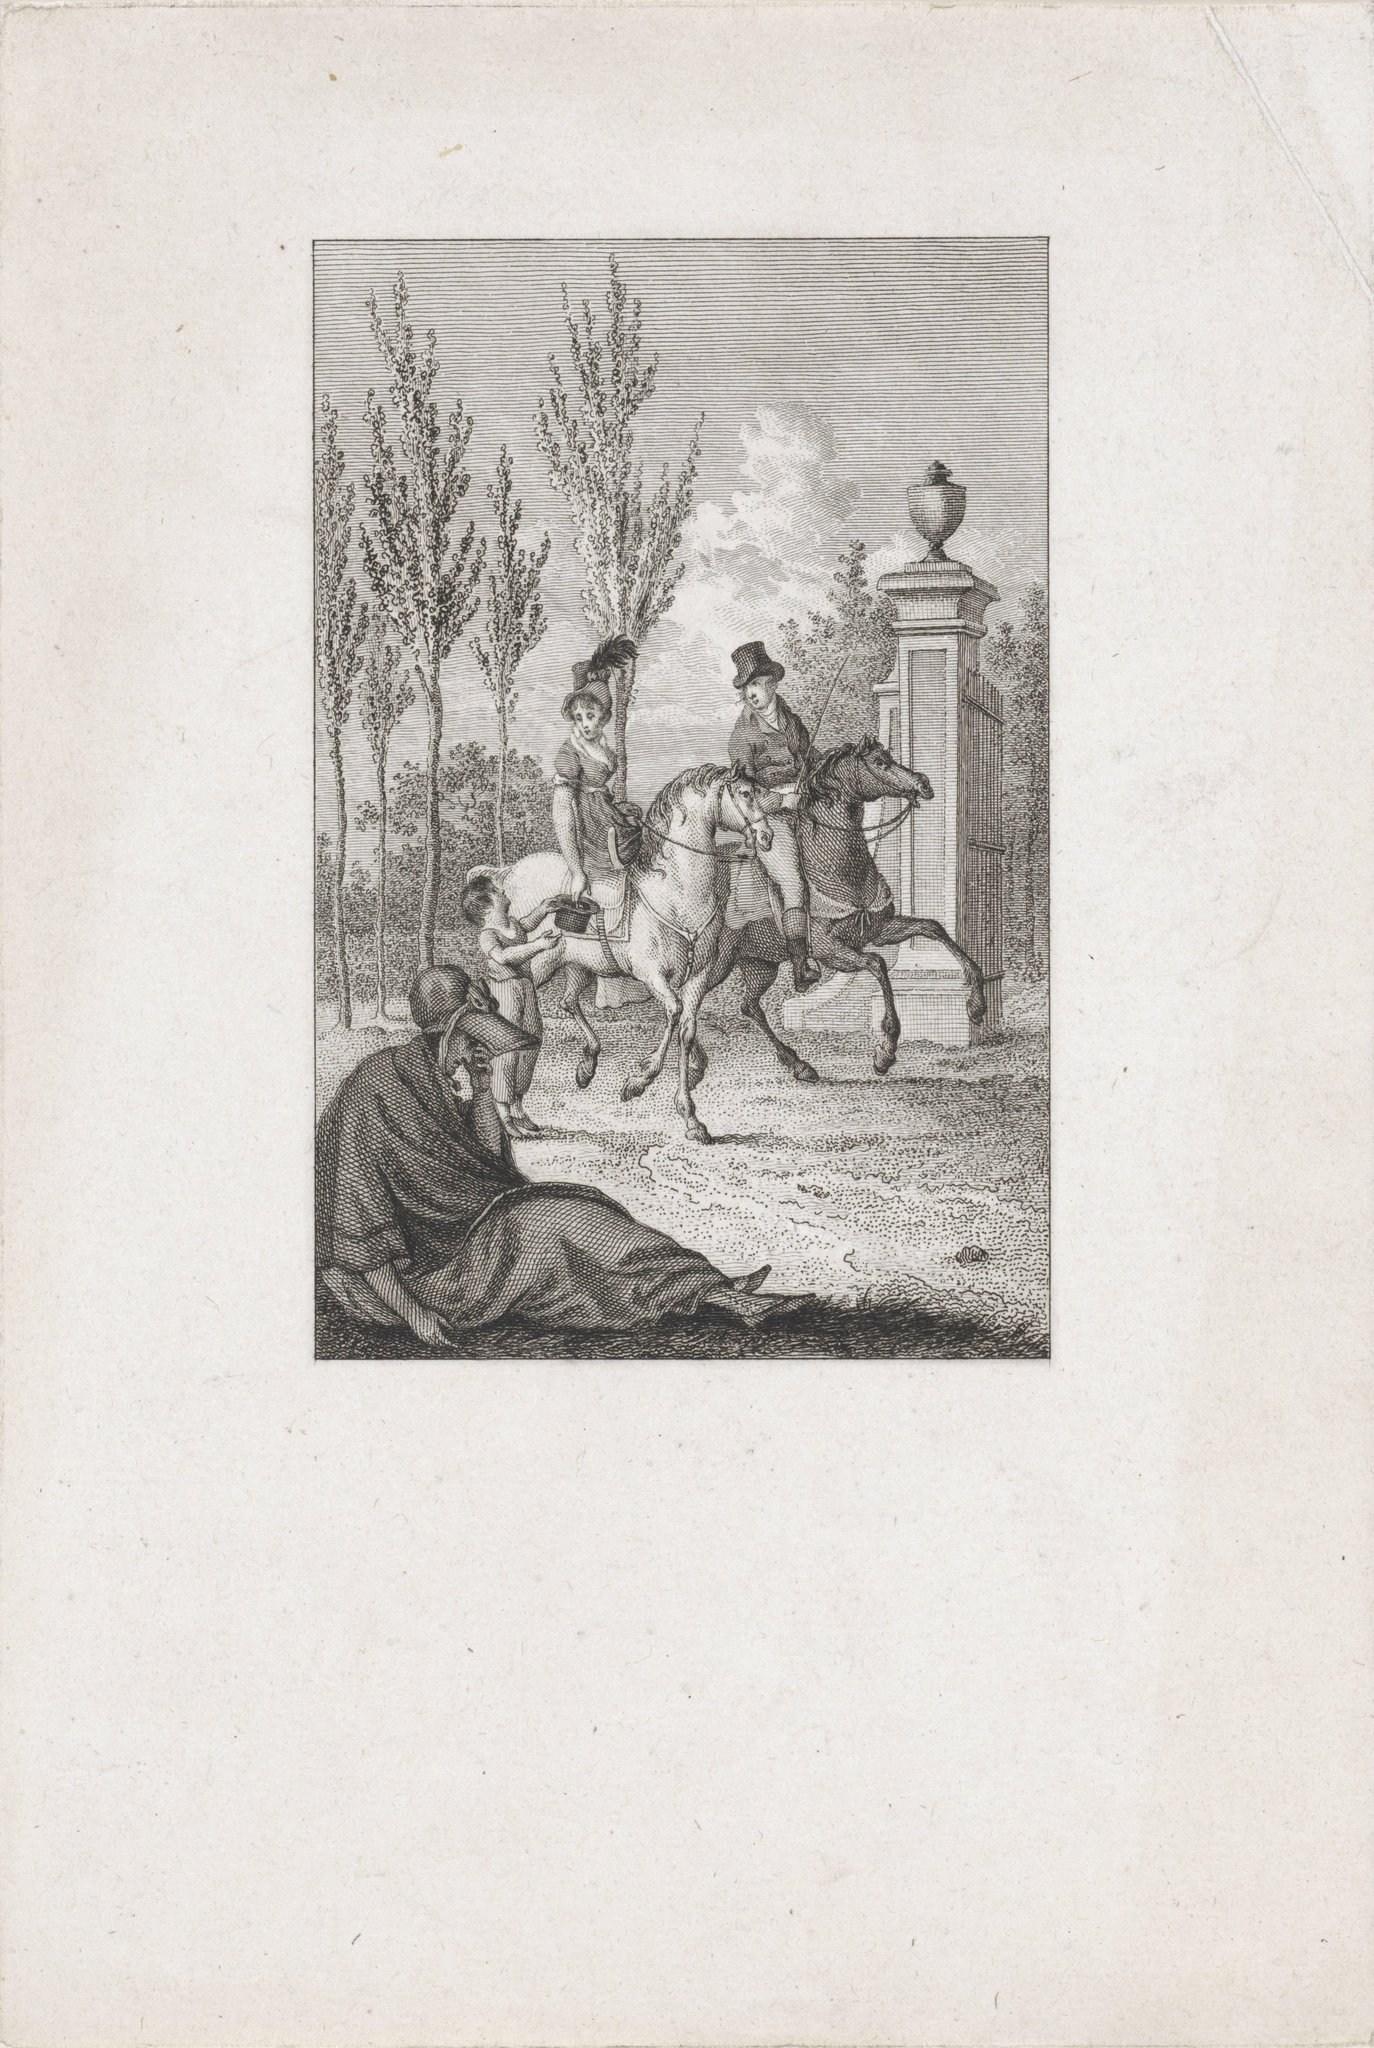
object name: print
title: Ruiter geeft een bedelende jongen munten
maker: reinier vinkeles (i)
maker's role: draughtsman, print maker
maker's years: 1741-1816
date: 1806-1807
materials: paper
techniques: engraving, etching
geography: amsterdam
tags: riding a horse, ass, or mule; rider, horseman, landscapes, beggar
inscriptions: collector's mark: Lugt 2228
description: Proefdruk van een prent die ook is gebruikt als illustratie in: Loosjes Pz., Adriaan. Historie van Mejuffrouw Susanna Bronkhorst. Haarlem: Adriaan Pz. Loosjes, 1806-1807.